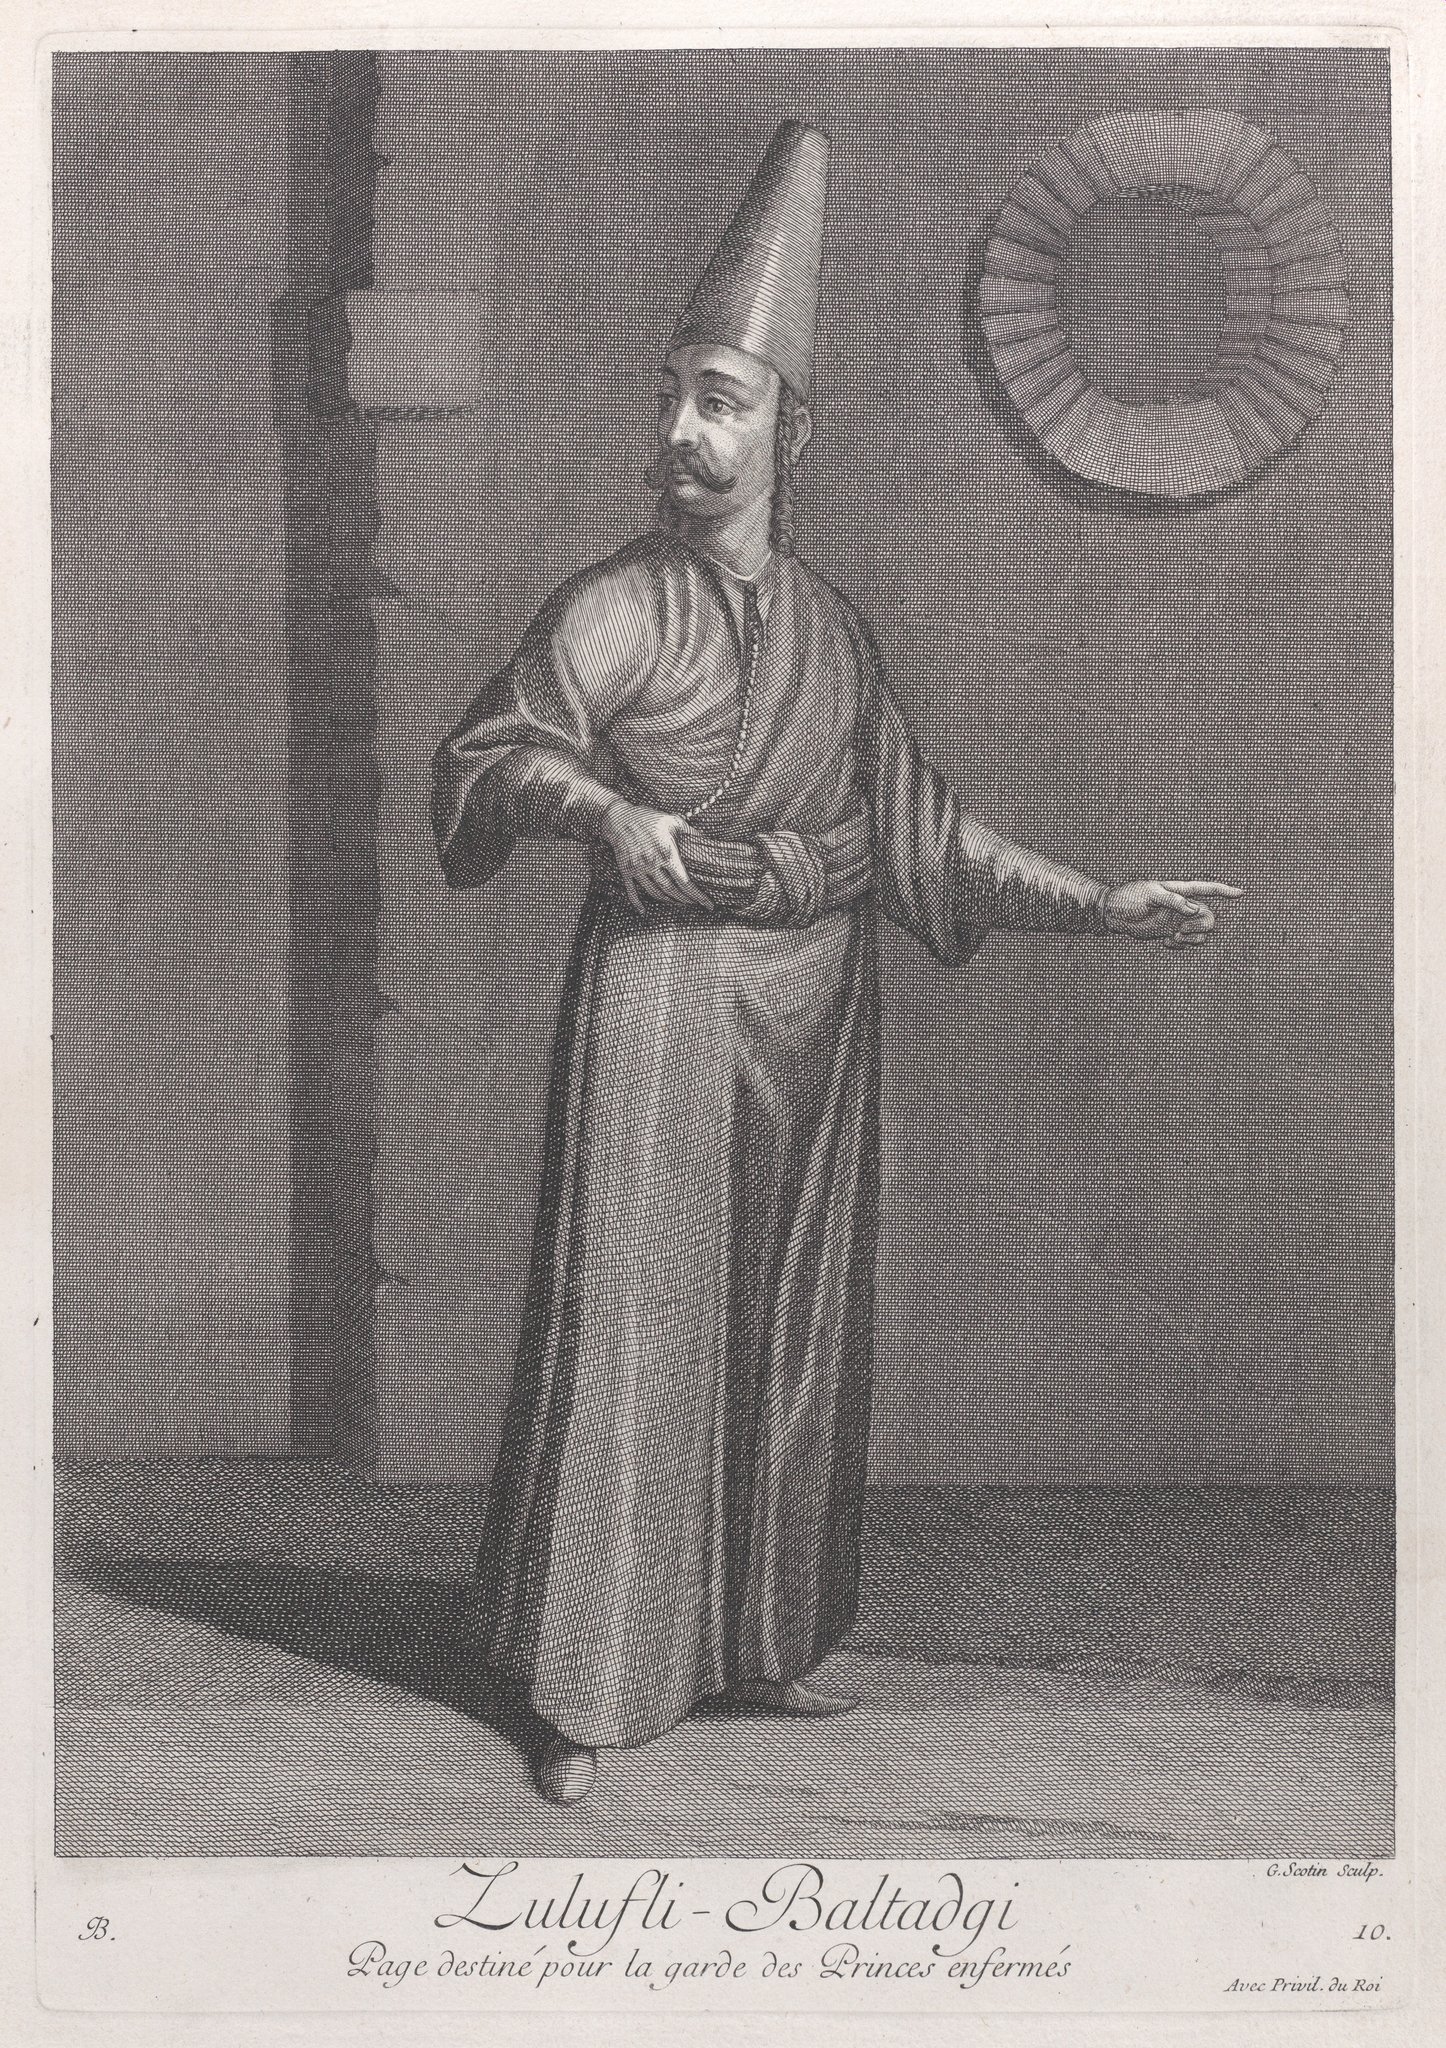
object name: print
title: Zulufli-Baltadgi, Page destiné pour la garde des Princes enfermés, plate 10 from "Recueil de cent estampes représentent differentes nations du Levant"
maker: jean baptiste vanmour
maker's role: artist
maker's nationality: french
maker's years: 1671-1737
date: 1714-1715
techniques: engraving, etching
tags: men